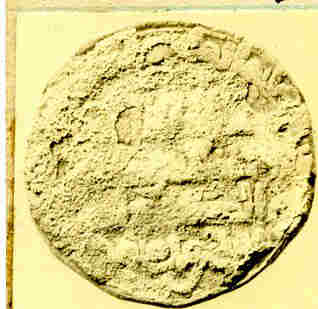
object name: coin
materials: silver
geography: iran